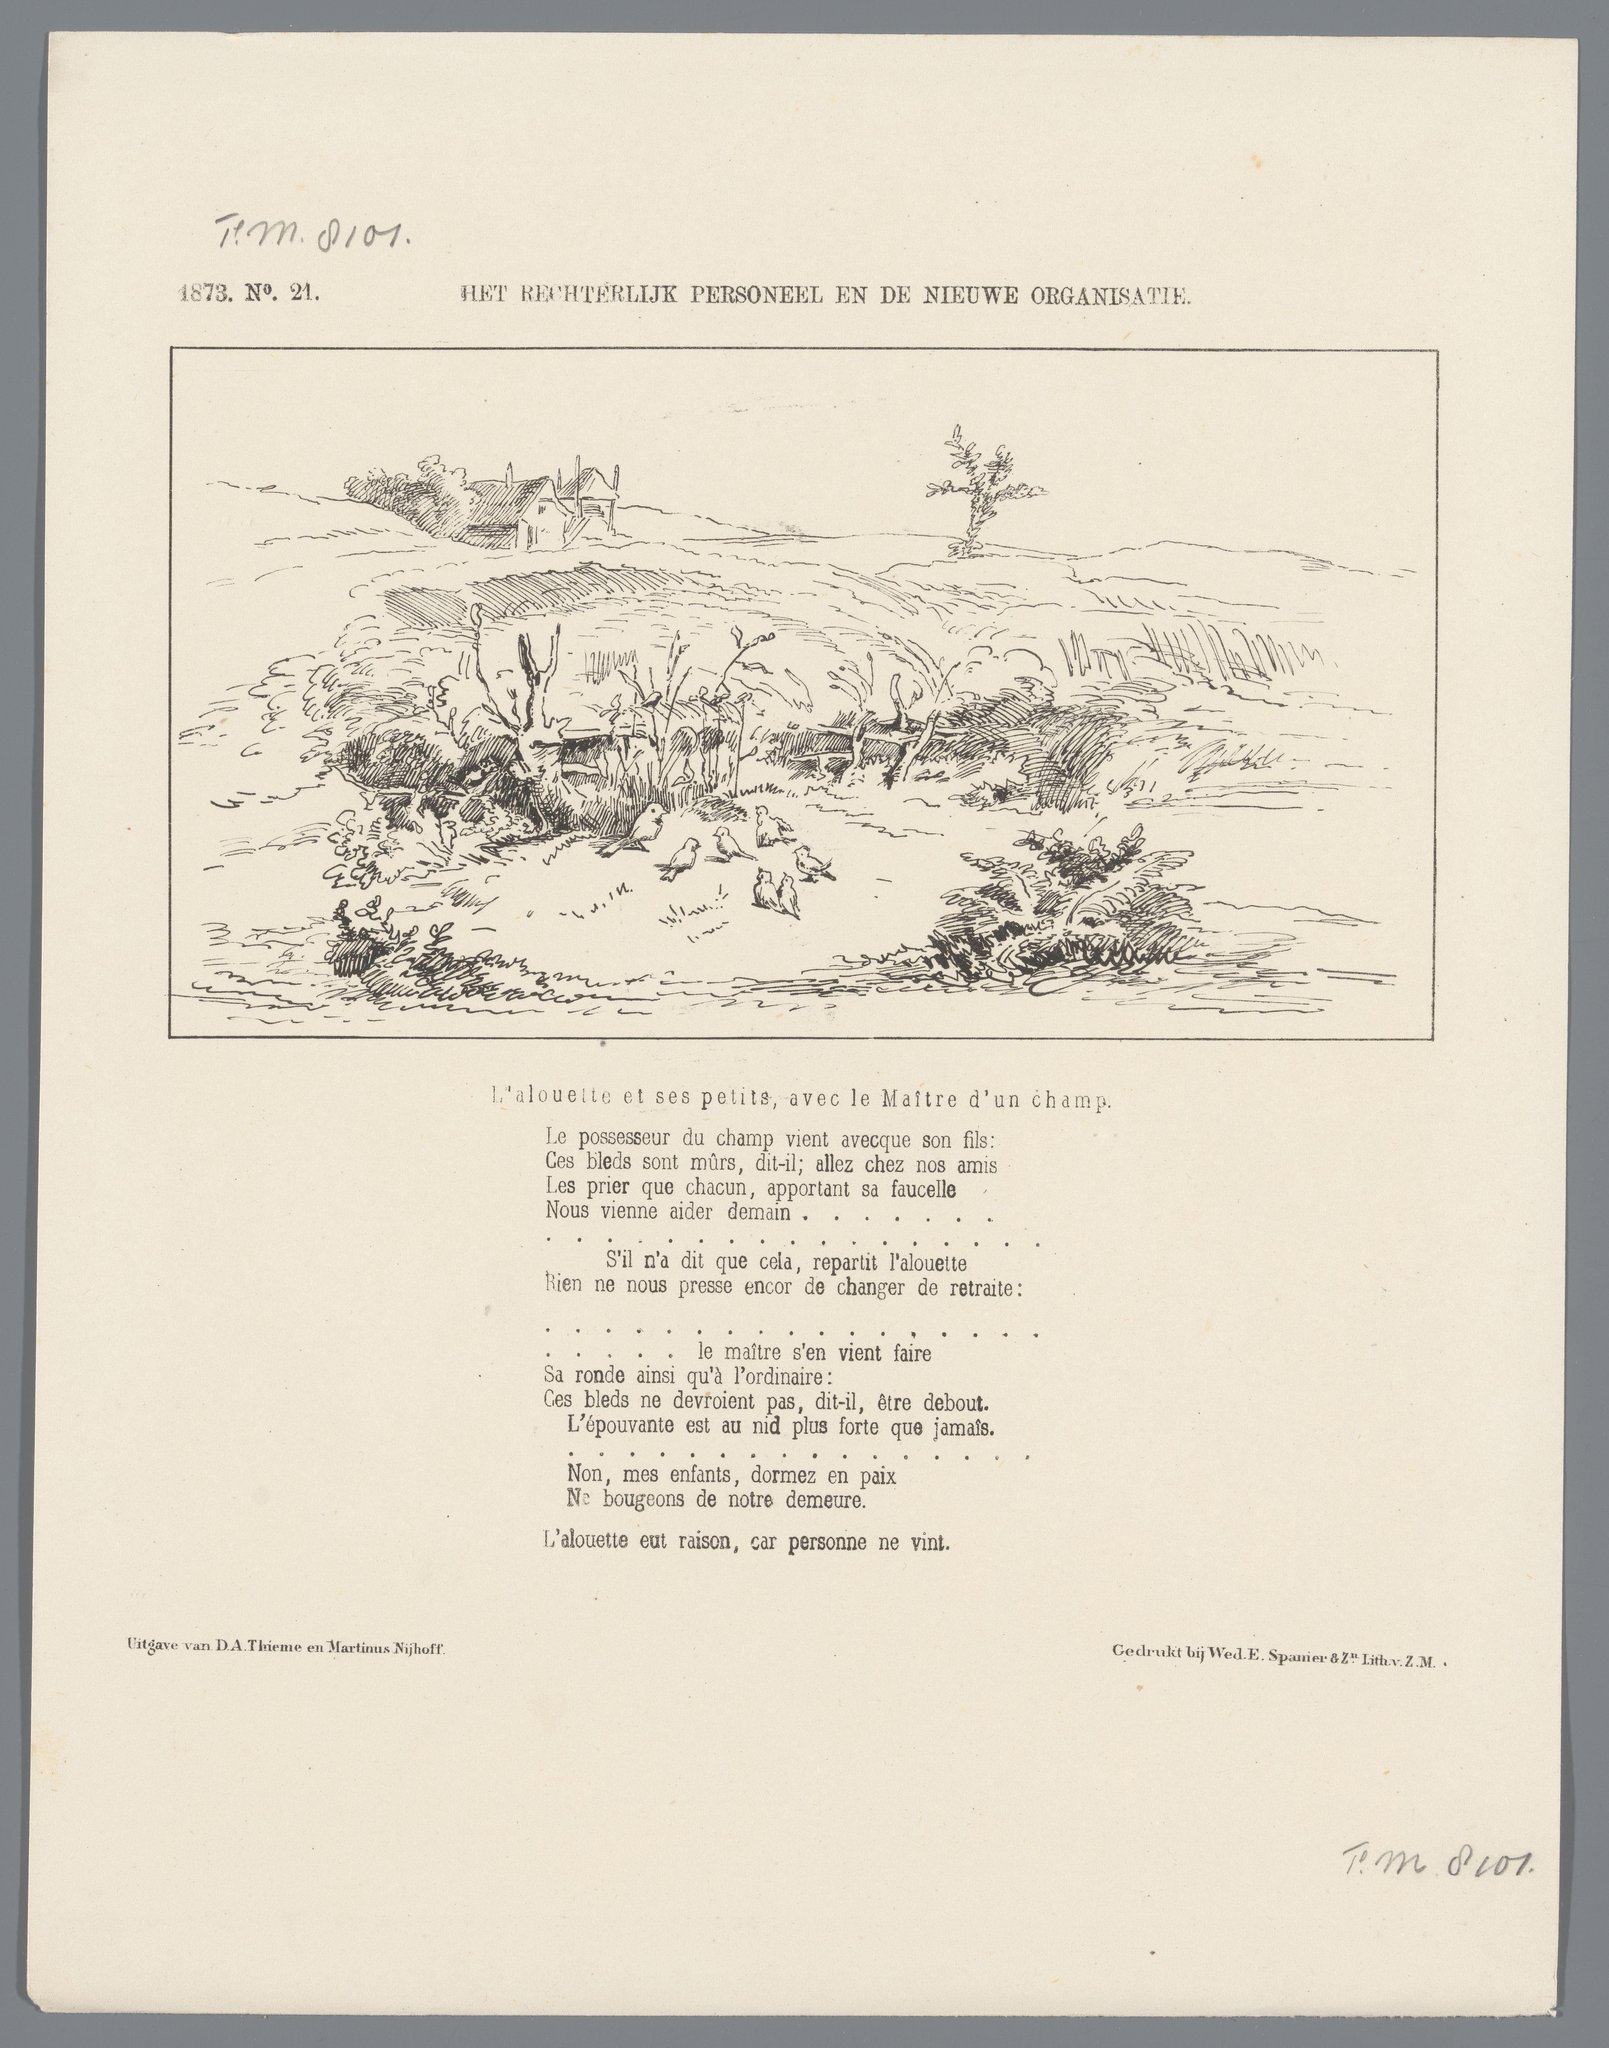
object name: cartoon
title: Spotprent op de hervorming van de rechterlijke organisatie, 1873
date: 1873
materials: paper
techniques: lithograph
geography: arnhem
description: Spotprent op het waarschijnlijk mislukken van de plannen voor de hervorming van de rechterlijke organisatie. Plaat verschenen bij het weekblad De Nederlandsche Spectator, nr. 21, 1873.